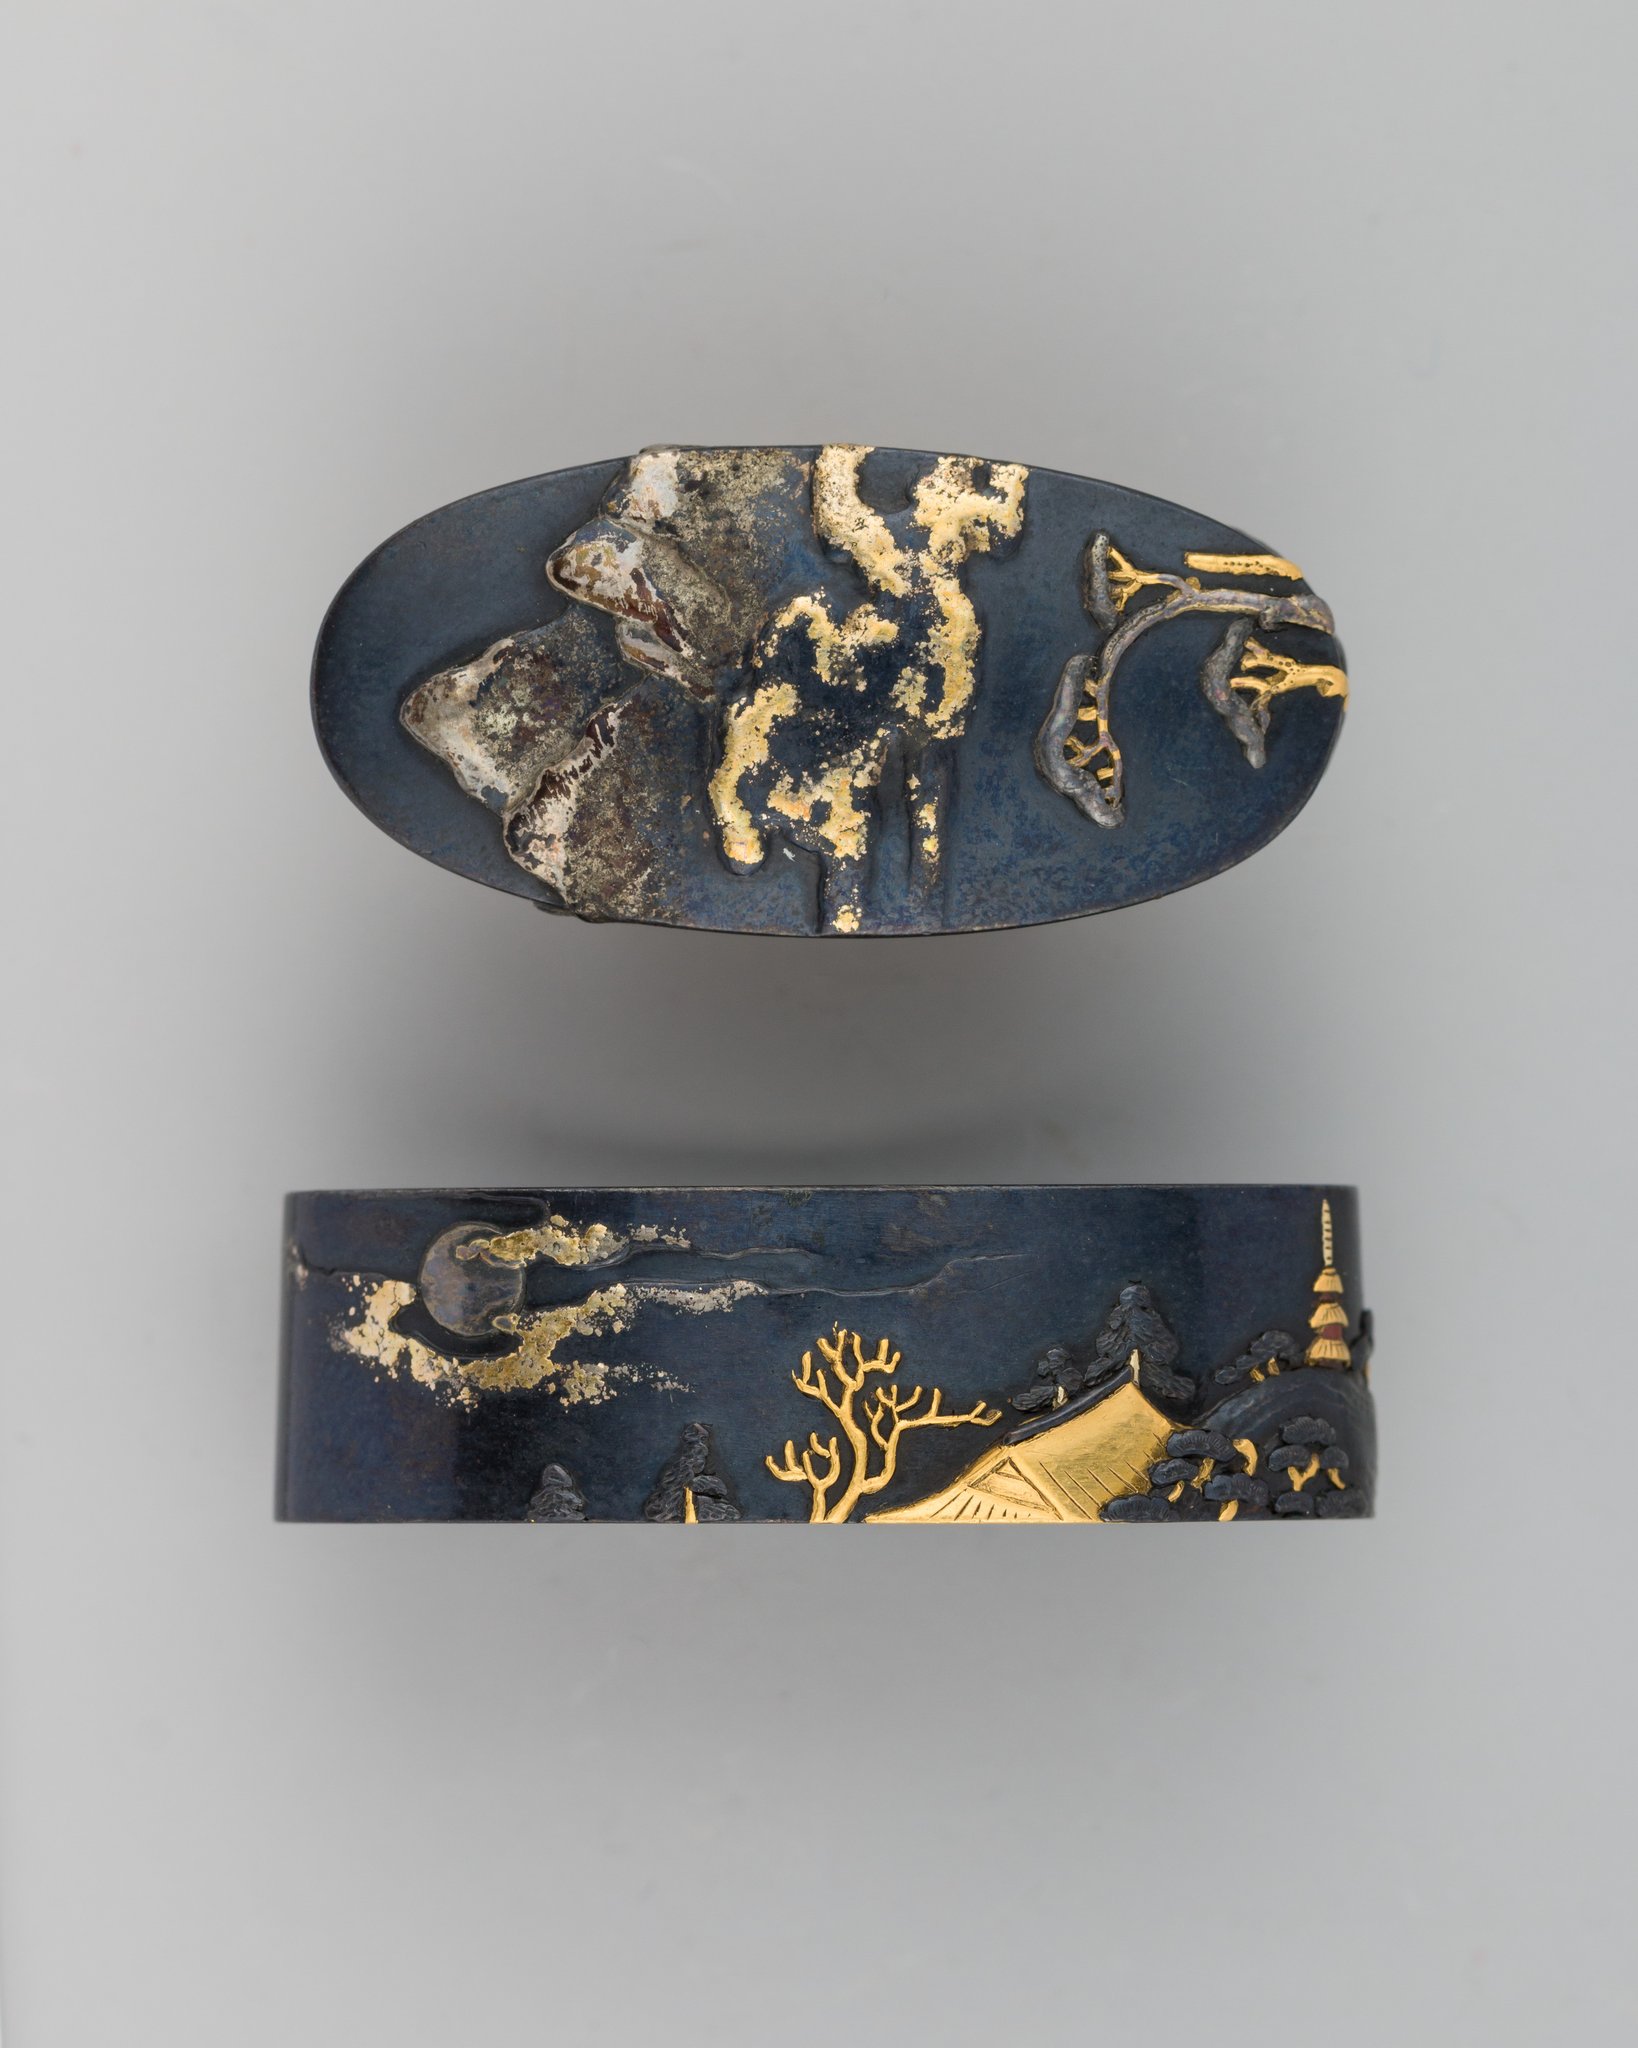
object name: sword hilt collar and pommel fuchigashira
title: Sword-Hilt Collar and Pommel (Fuchigashira)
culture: japanese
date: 1801-1833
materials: gold alloy, gold, silver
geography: japan